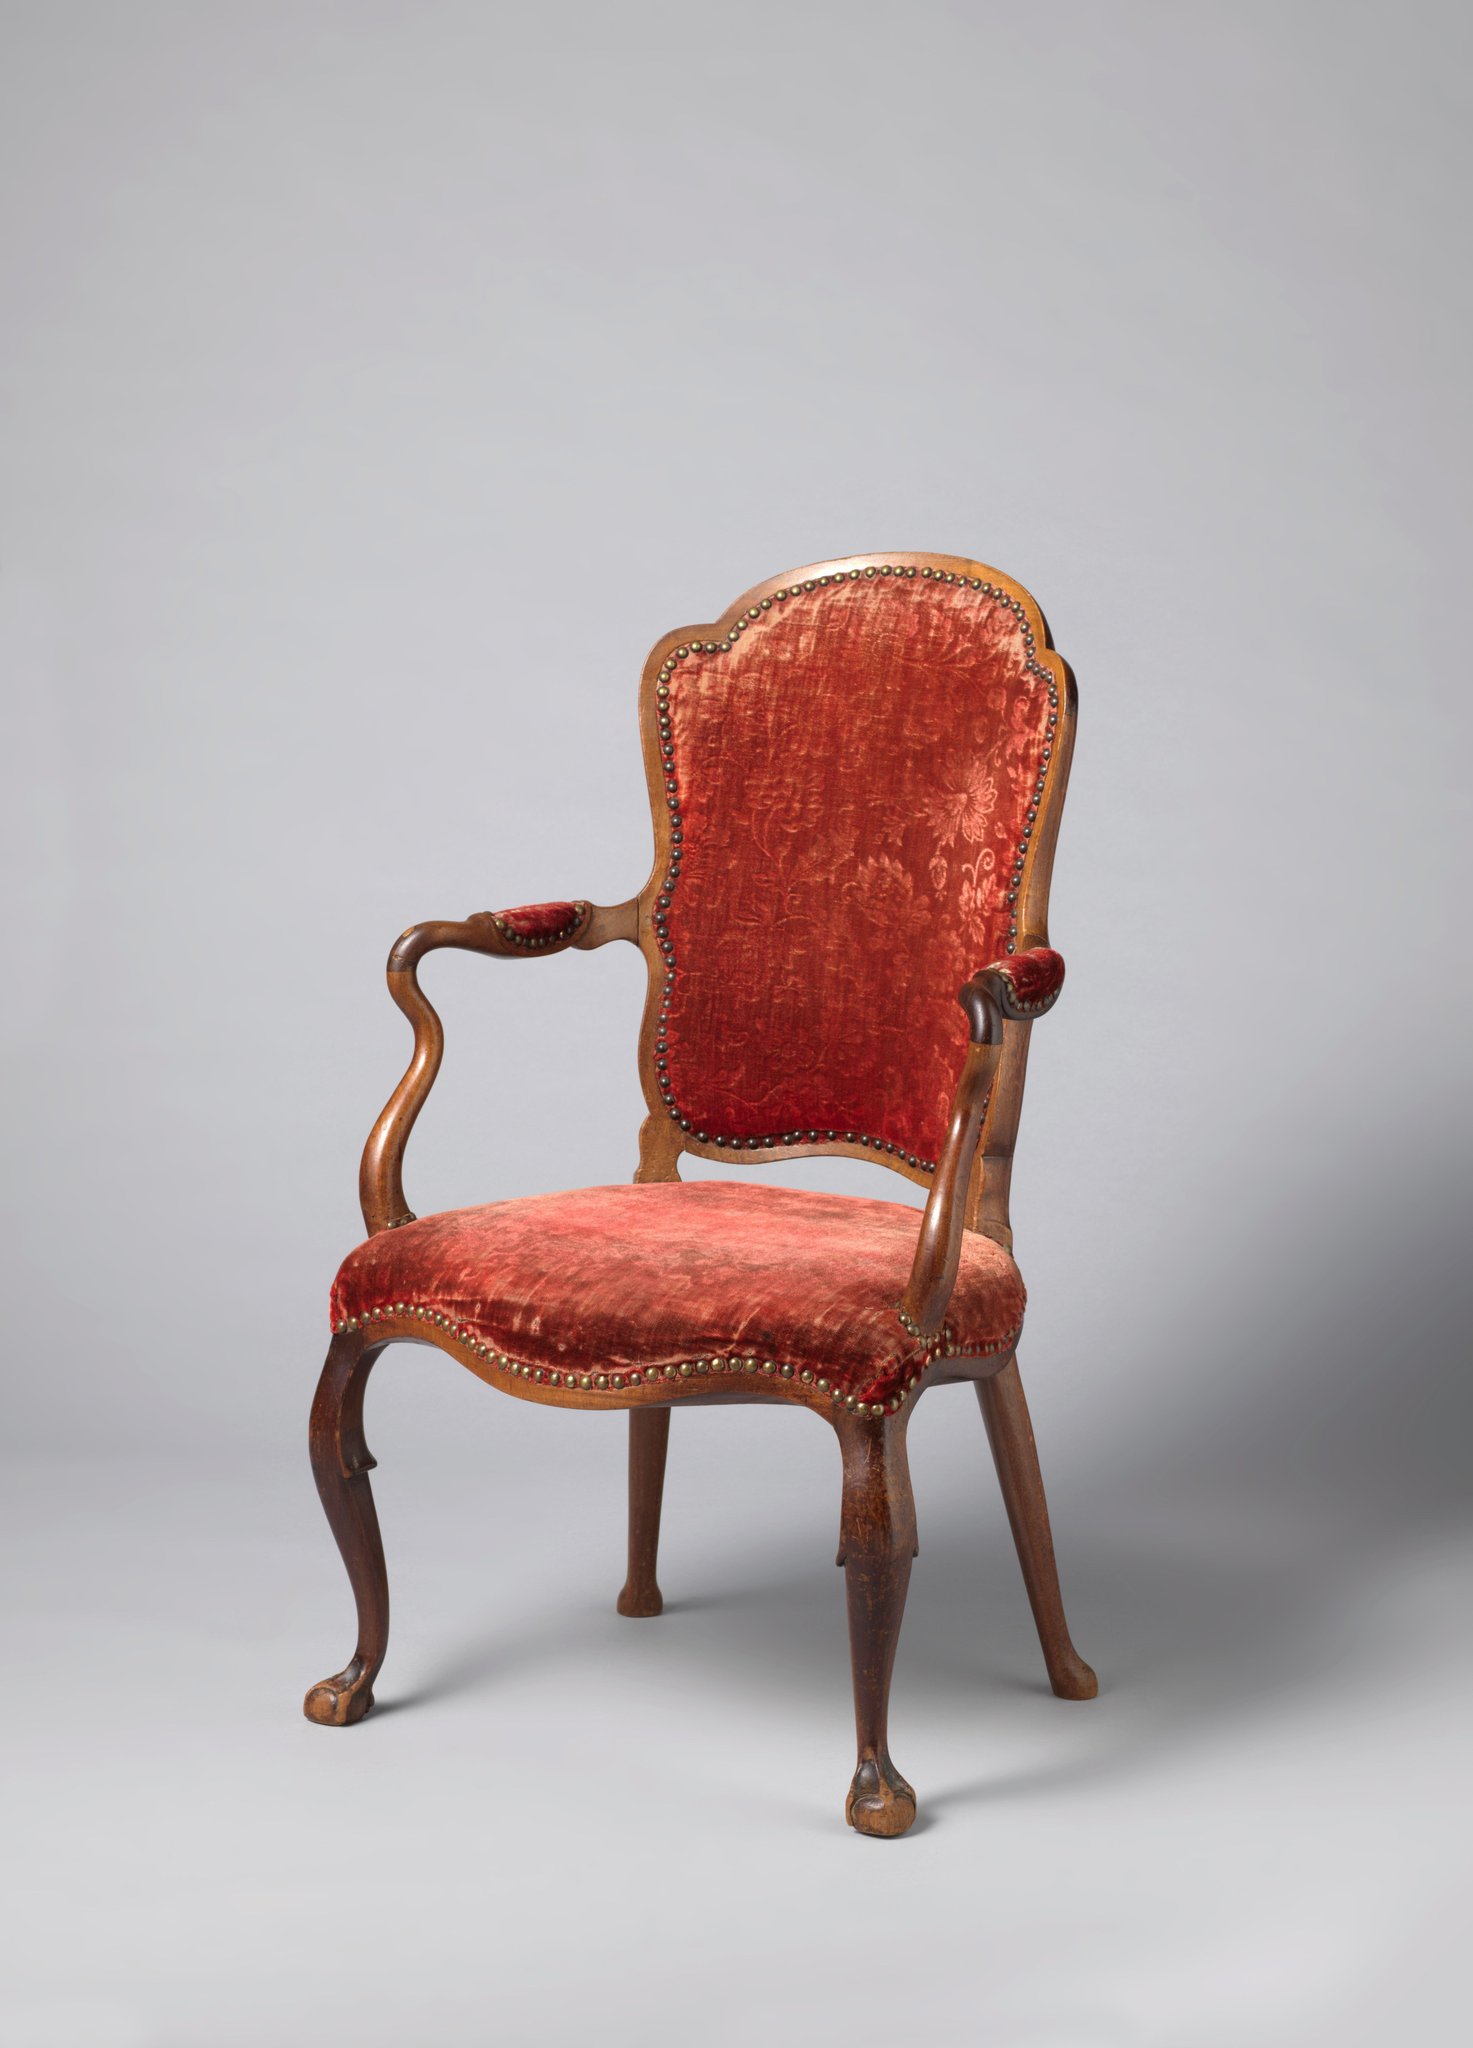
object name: armchair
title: Stoel van Henriëtte Roland Holst - van der Schalk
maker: Anonymous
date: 1700-1799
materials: velvet, wood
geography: netherlands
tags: amsterdam, henriëtte roland holst-van der schalk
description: Stoel van Henriëtte Roland Holst - van der Schalk. Houten armstoel bekleed met rood reliëffluweel. Bekleding heeft bloem- en bladmotieven.